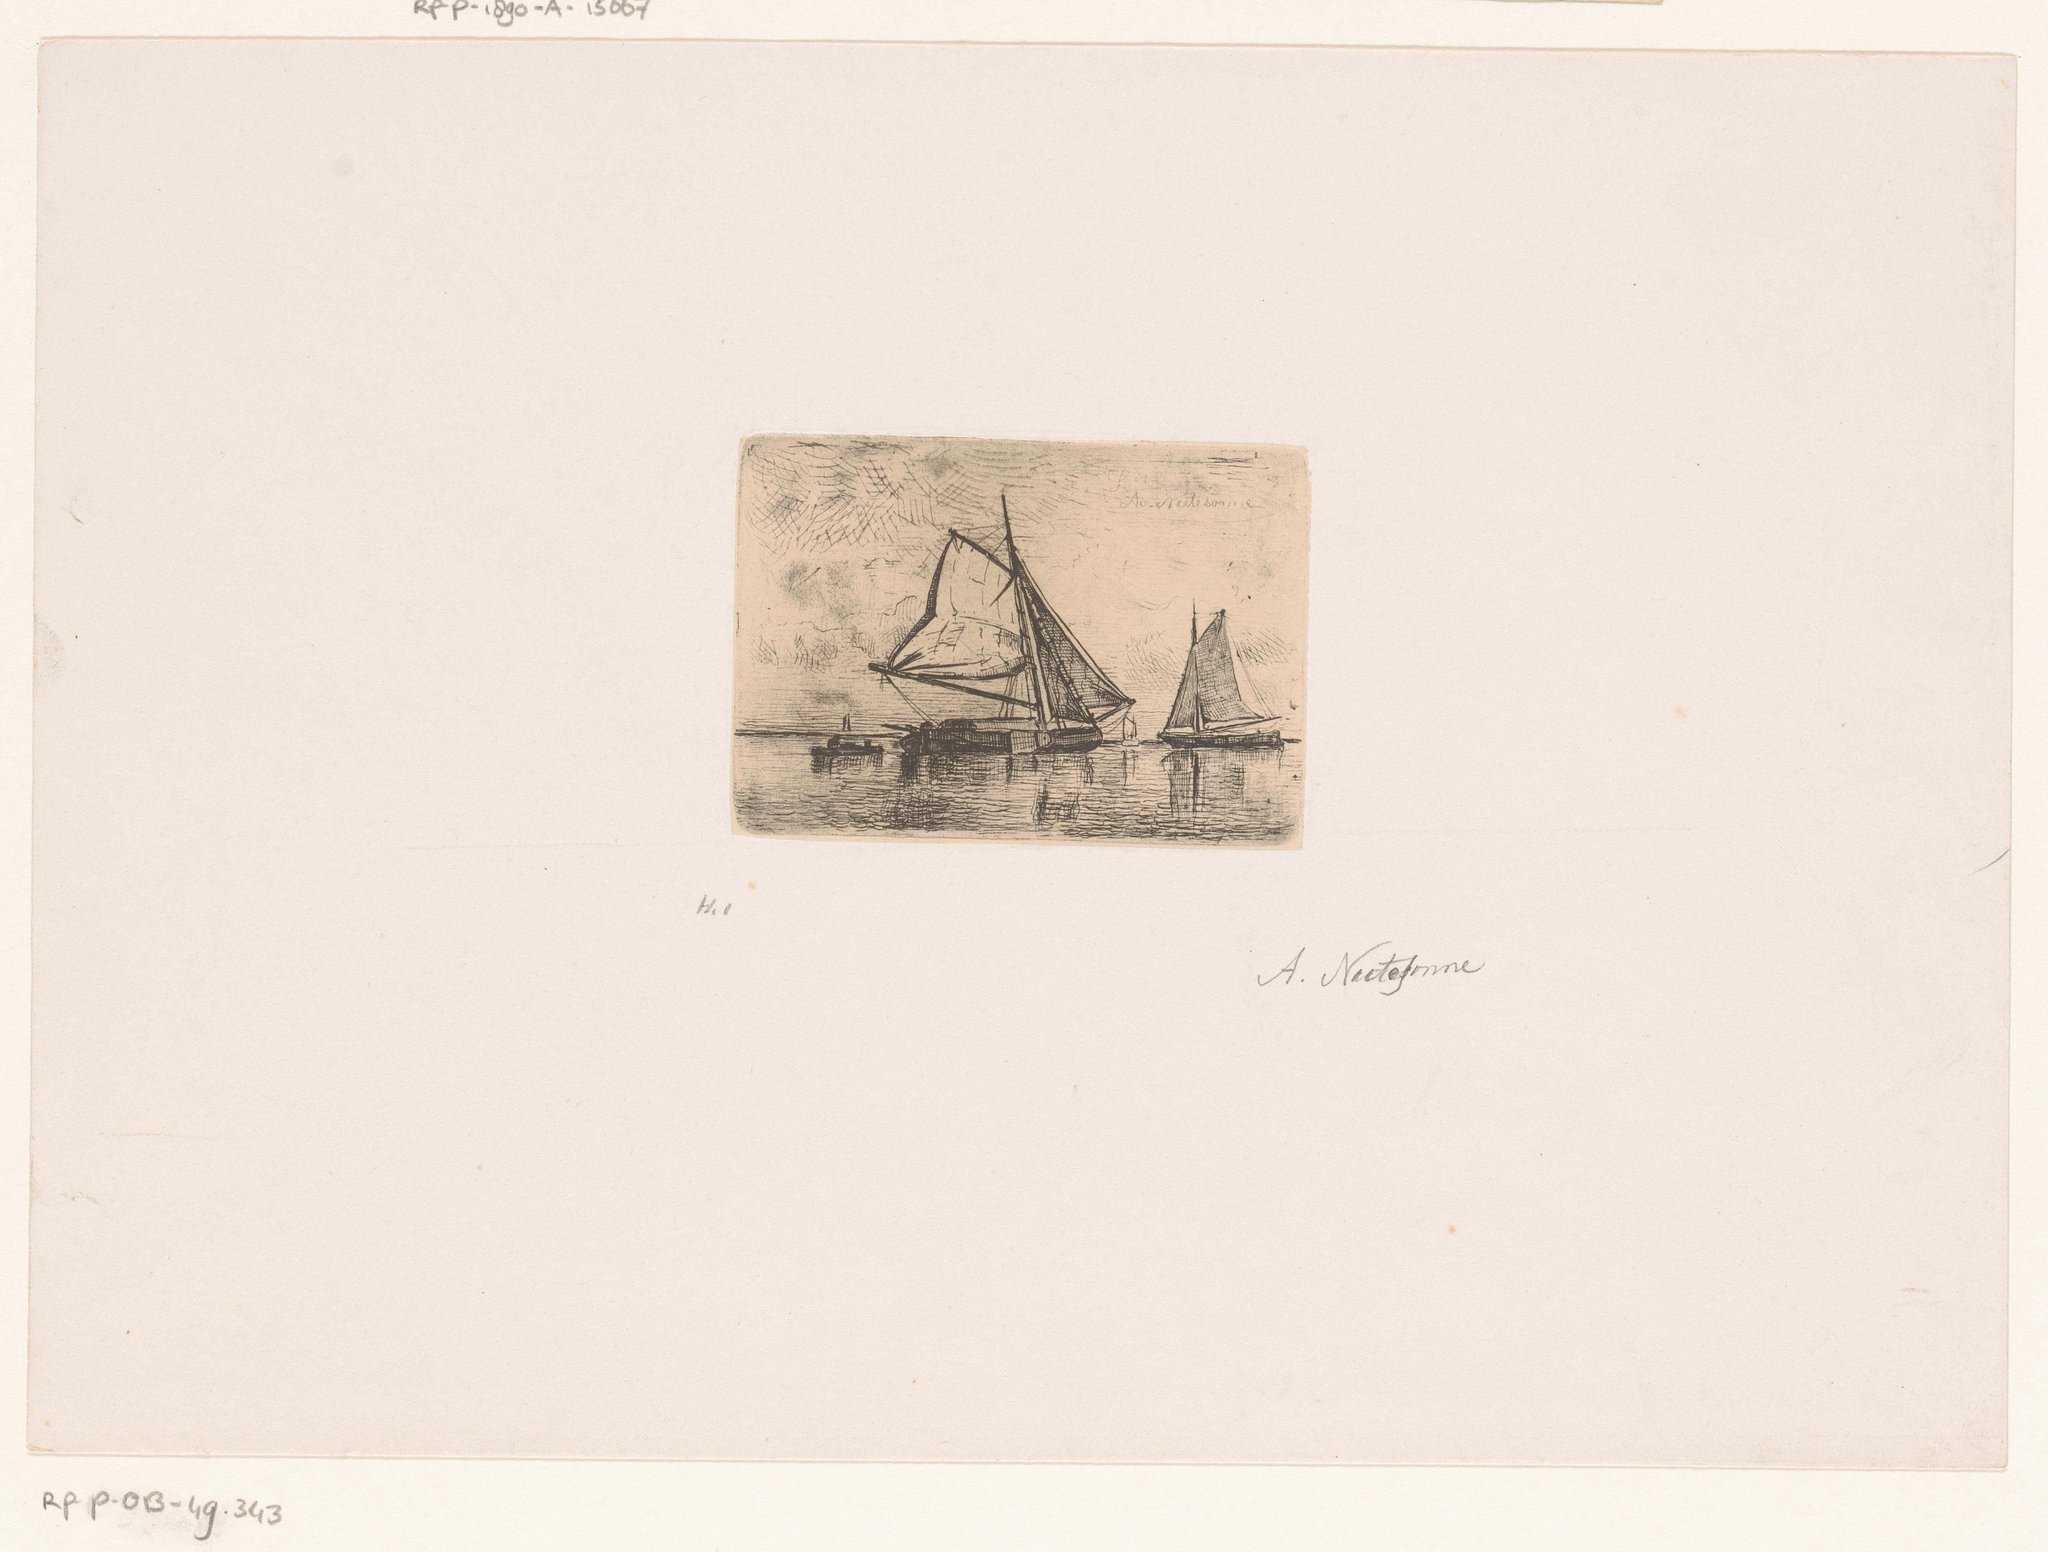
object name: print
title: Schepen op de Schelde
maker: l.a. neetesonne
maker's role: print maker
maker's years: 1865-1891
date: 1865-1879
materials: paper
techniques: etching, intaglio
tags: sailing-ship, sailing-boat, landscapes with waters, waterscapes, seascapes (in the temperate zone)